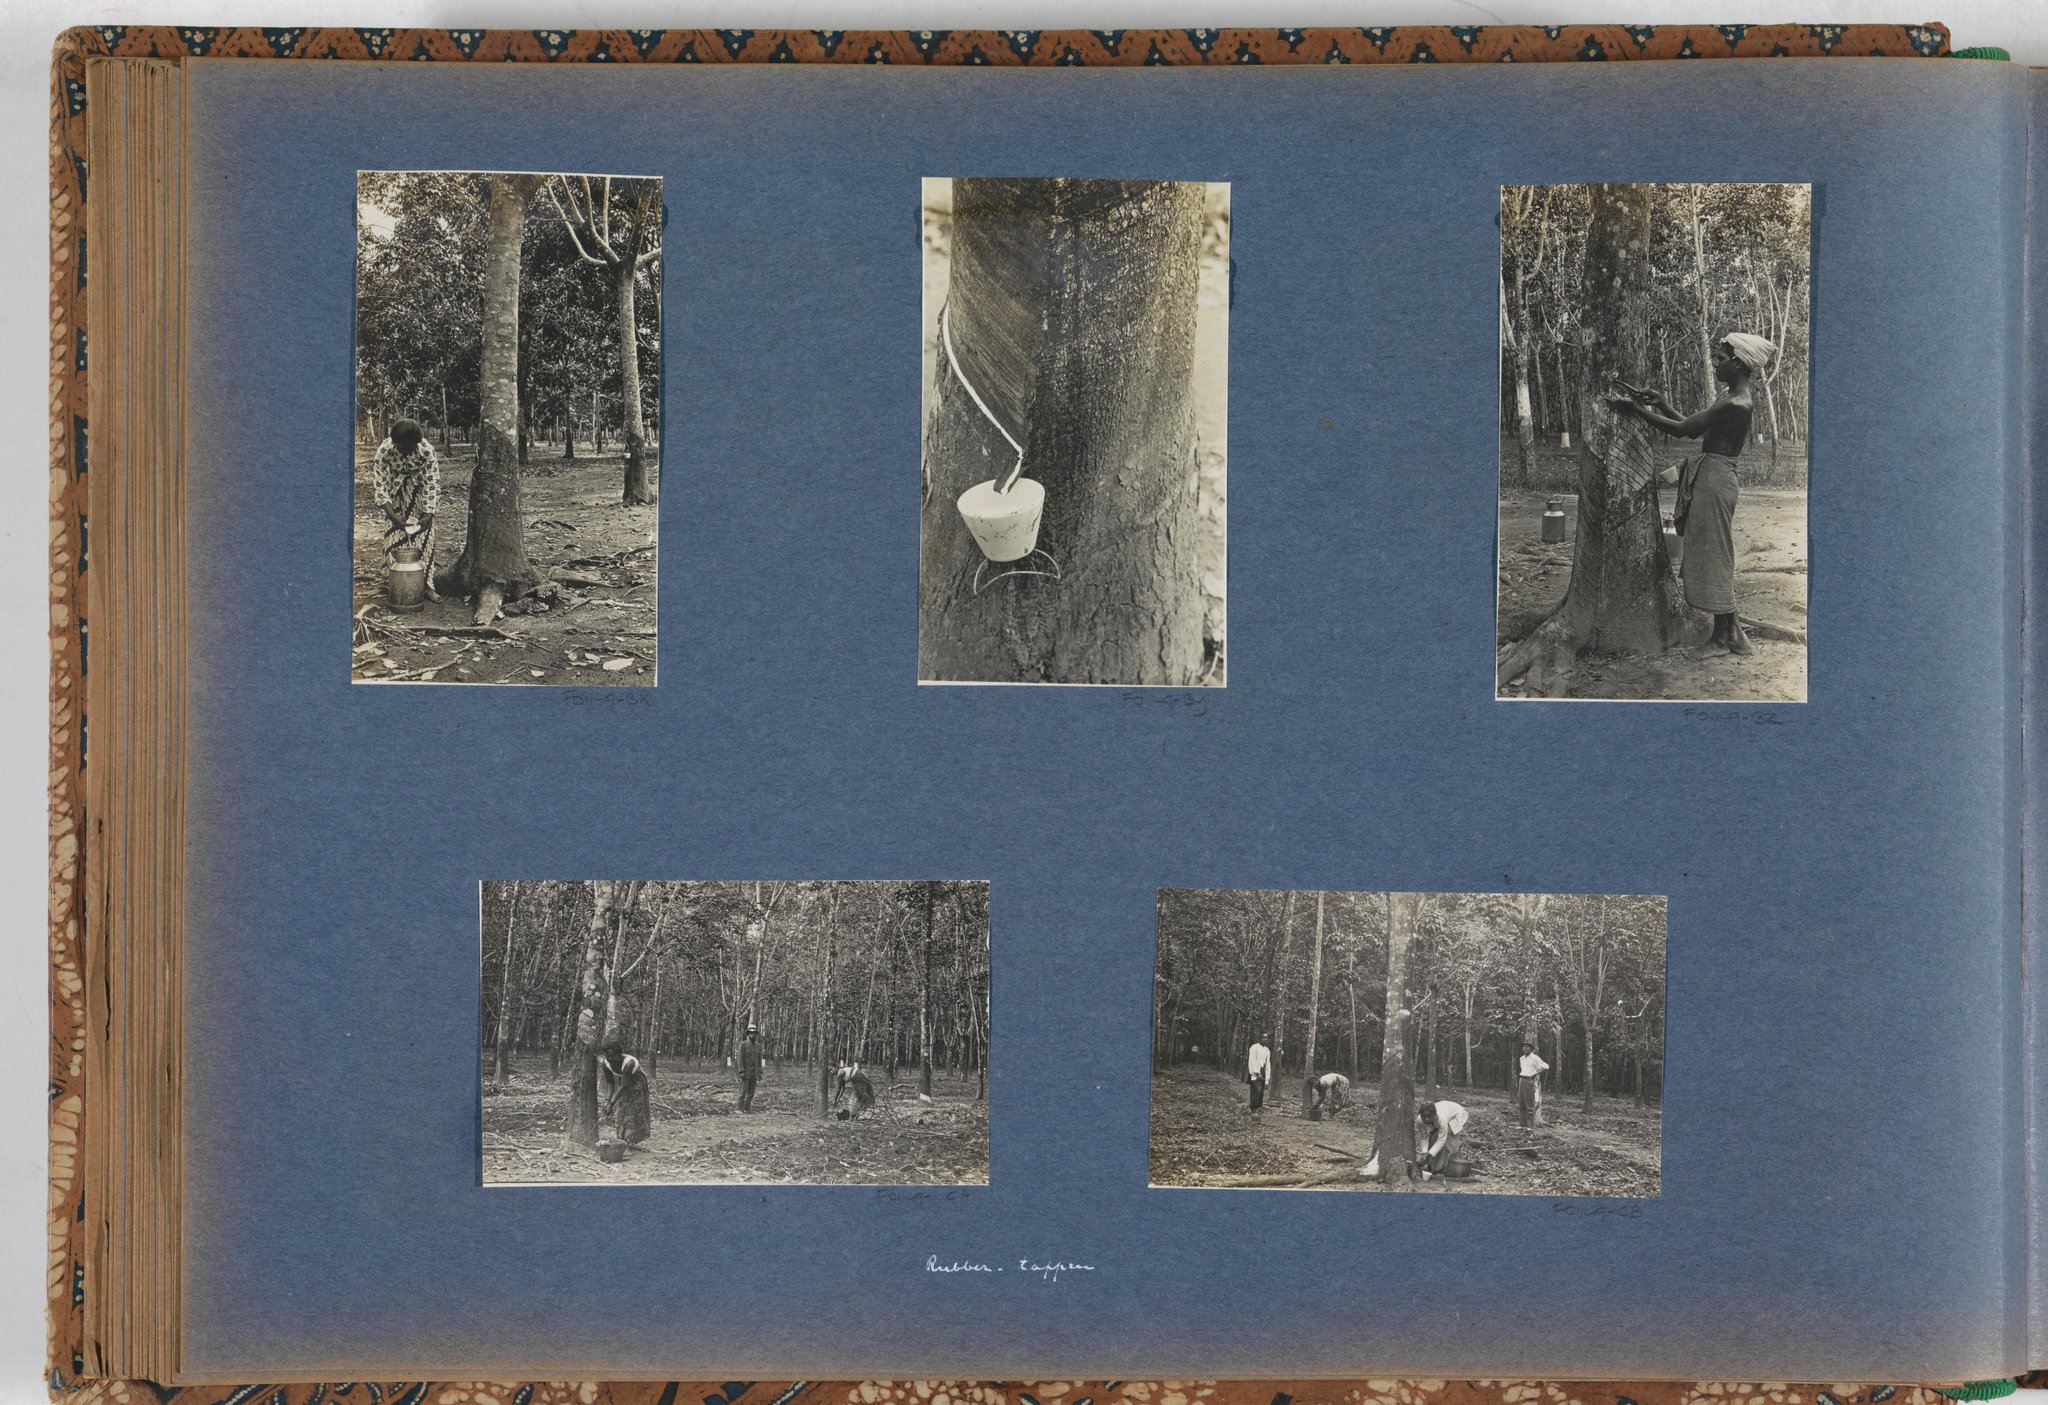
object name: photograph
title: Vrouw tapt rubber op een plantage op Sumatra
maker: Anonymous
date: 1900-1920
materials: paper, photographic support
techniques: gelatin silver print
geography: sumatra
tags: plantation, (non-fruit) products of plants or trees: rubber, working class, labourers, sumatra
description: Mogelijk gaat het om een contractarbeidster. Onderdeel van reisalbum met foto's van bedrijvigheid en bezienswaardigheden op Sumatra en Java en van de reis naar en van Nederlands-Indië.